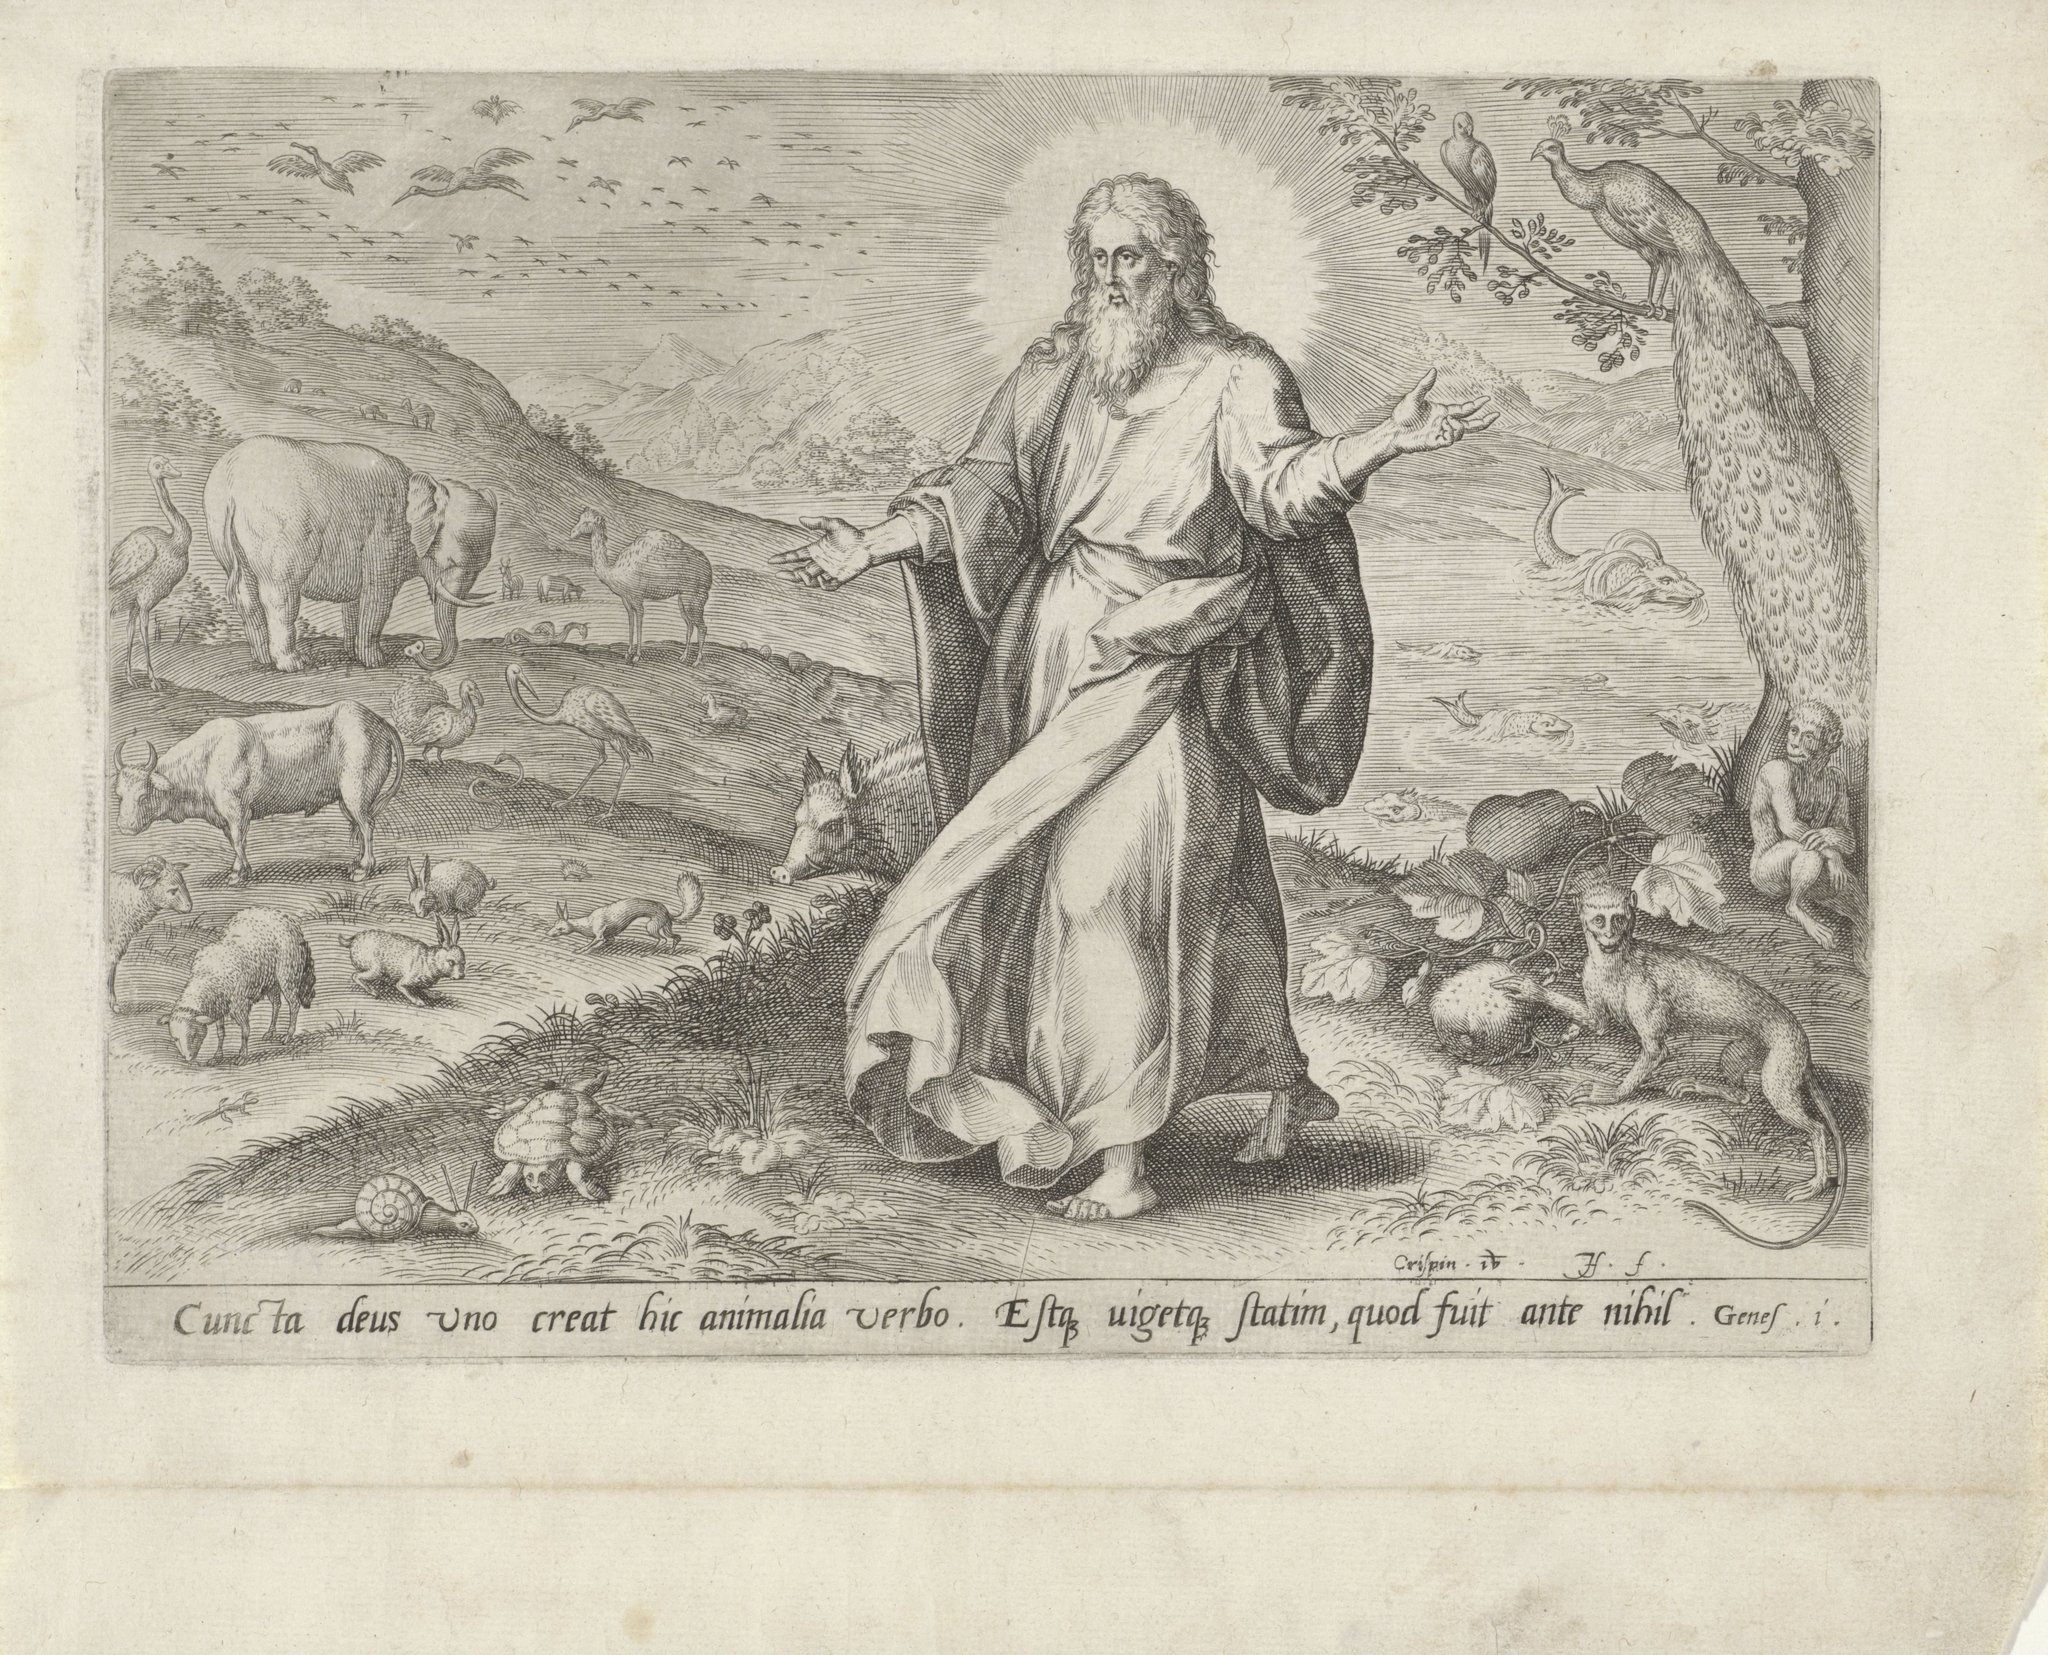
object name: print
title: Schepping en zondeval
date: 1575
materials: paper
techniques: engraving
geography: antwerp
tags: creation of the animals ~ genesis (+ god the father), animals, god the father as bearded old man, usually with crown or tiara or sceptre and/or globe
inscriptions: collector's mark: Lugt 2760, collector's mark: Lugt 2228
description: Dag vijf van de Schepping: God schept de dieren. God de Vader in de gedaante van een oude man, staand te midden van verschillende dieren. Vogels in de lucht. De tweede prent van een achtdelige reeks over het scheppingsverhaal.